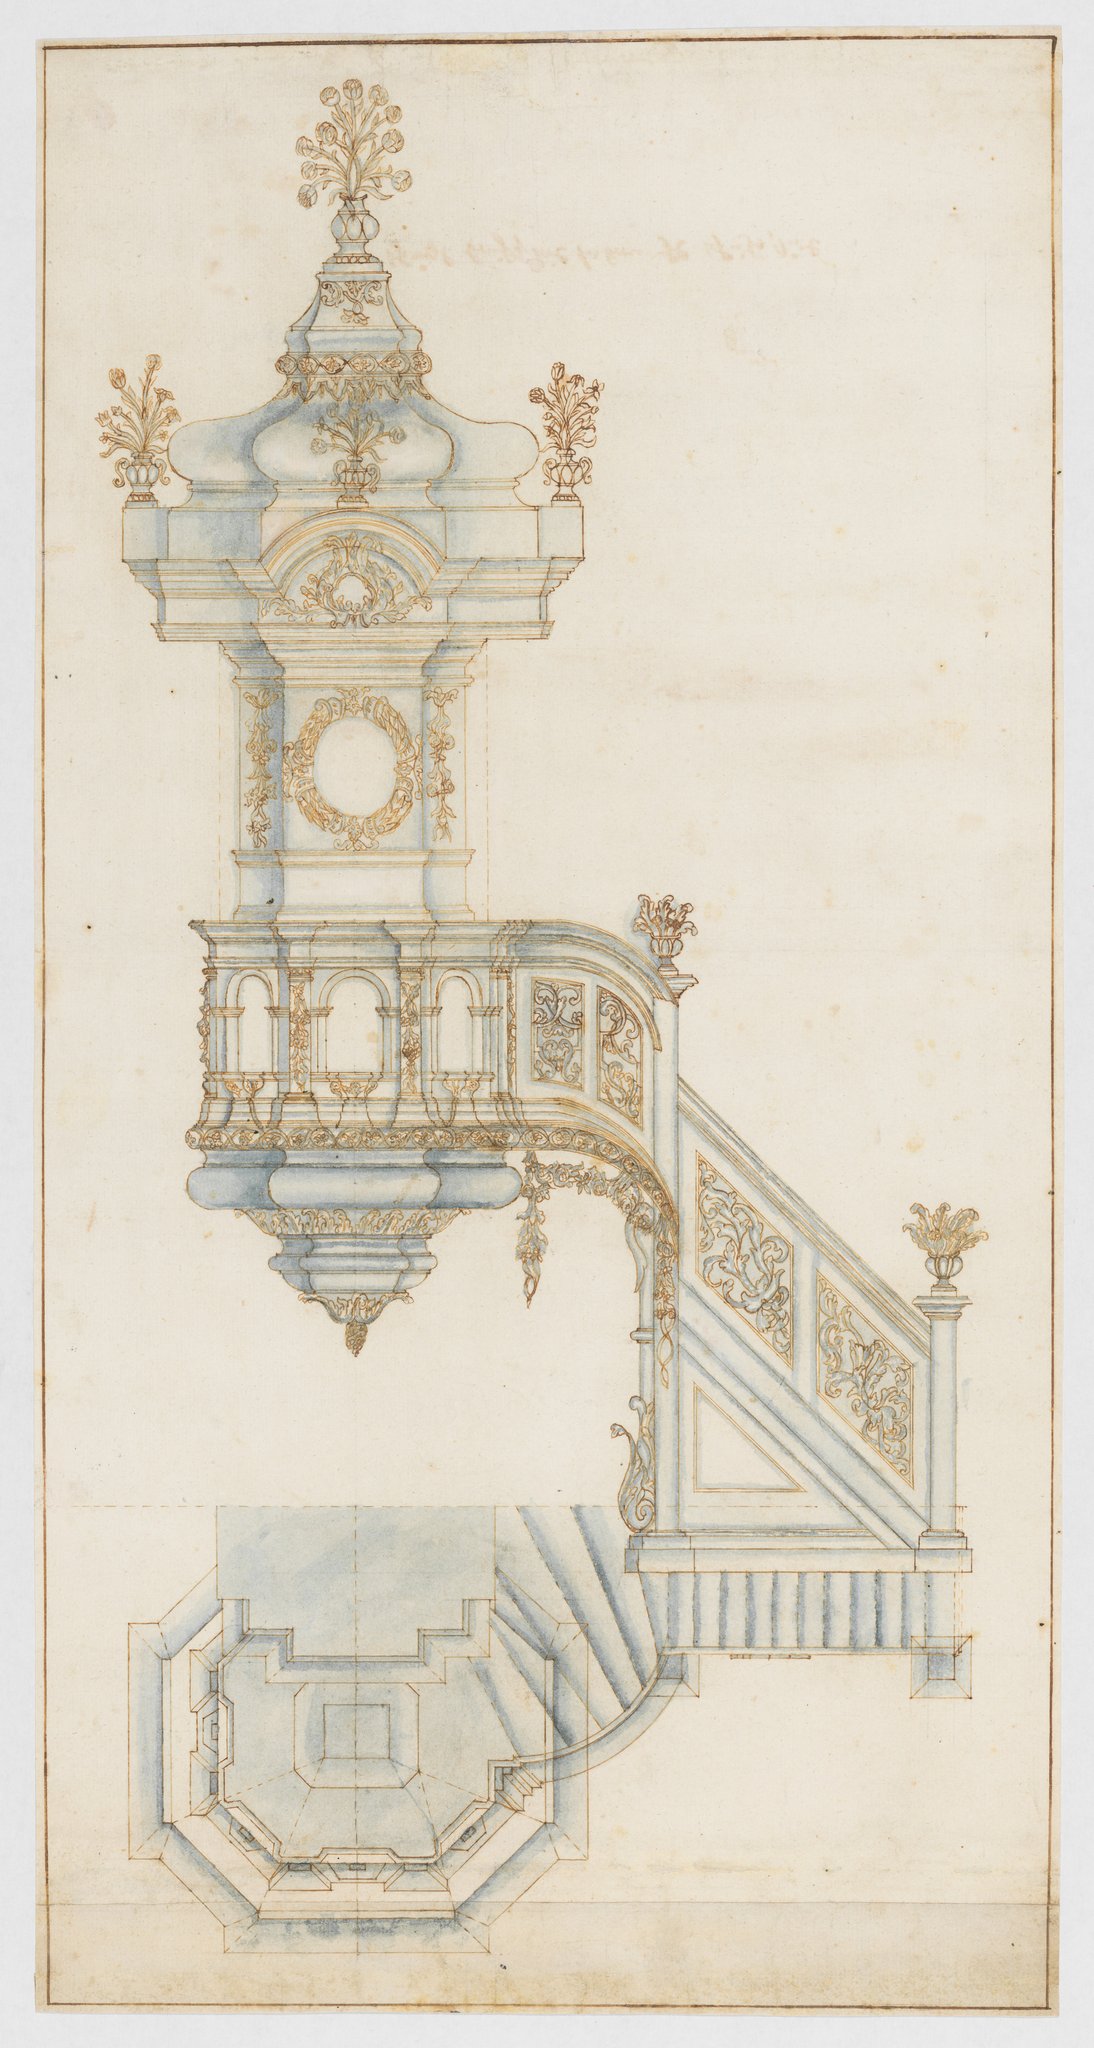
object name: drawing ornament architecture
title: Design for a Pulpit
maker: michael furtner the elder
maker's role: artist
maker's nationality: german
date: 1690-1720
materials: ink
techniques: brush, pen, wash